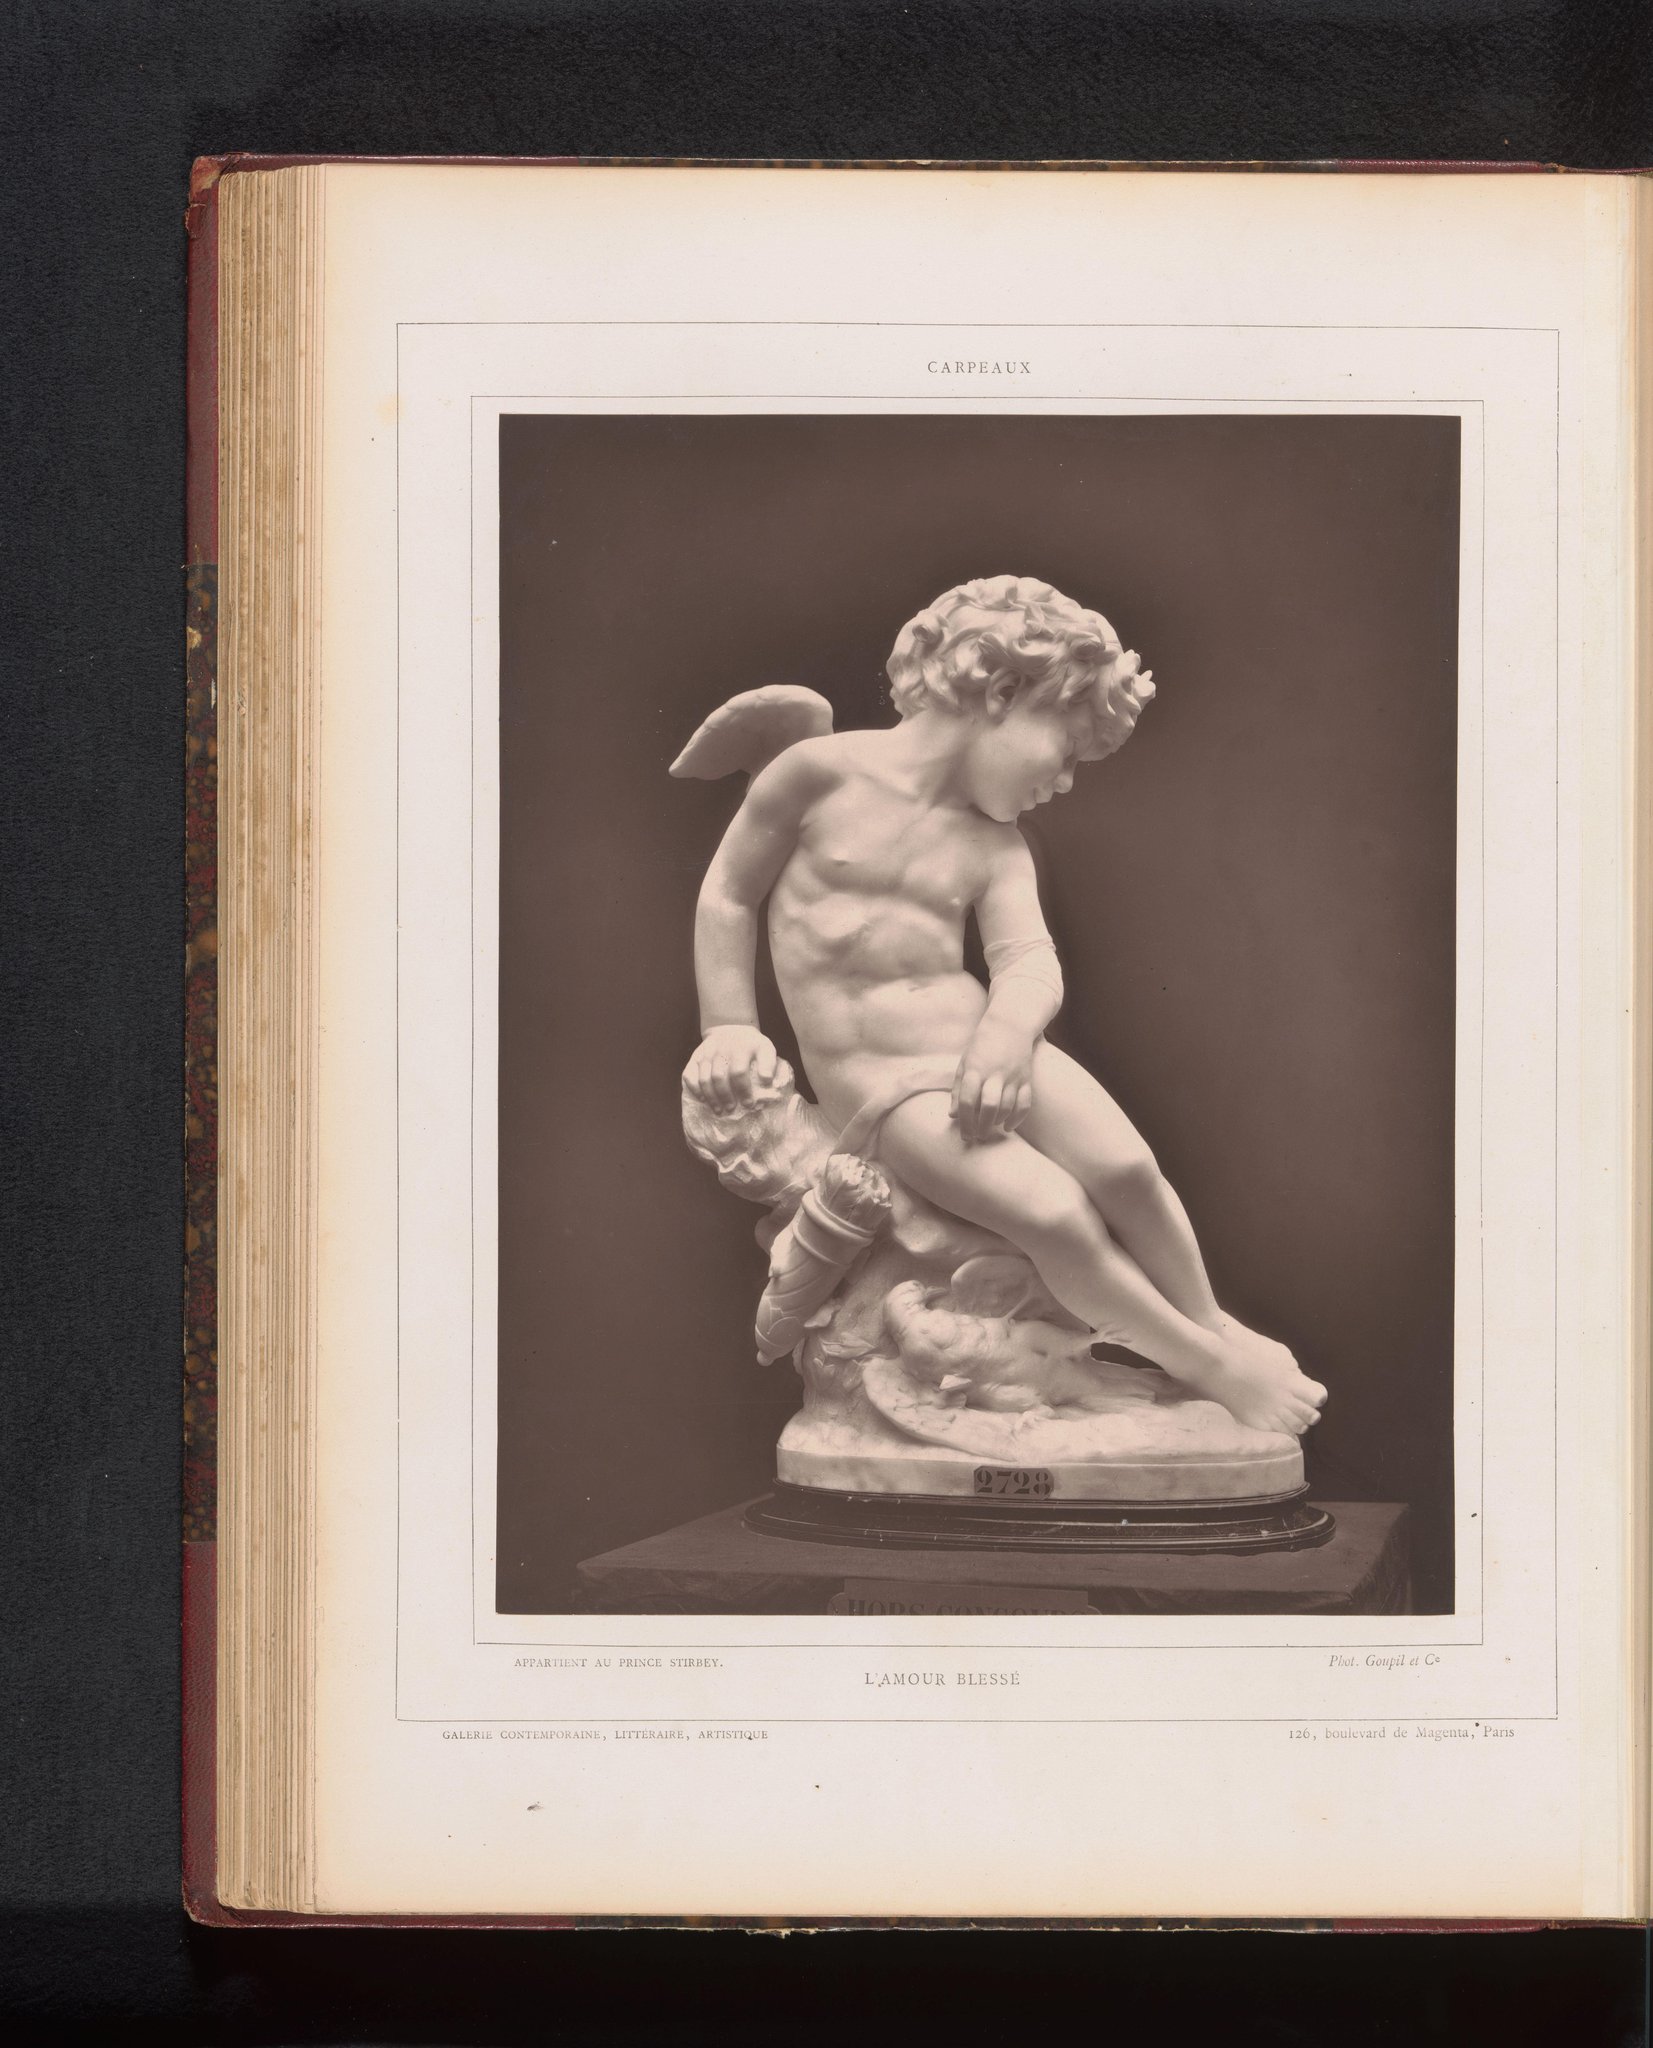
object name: page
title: Sculptuur L'Amour blessé door Jean-Baptiste Carpeaux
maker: Anonymous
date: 1872-1877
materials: paper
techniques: woodburytype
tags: sculpture, angels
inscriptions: inscription: ‘Carpeaux/ Appartient au Prince Stirbey/ Galerie Contemporaine, Littéraire et Artistique/ 126, boulevard de Magenta.’